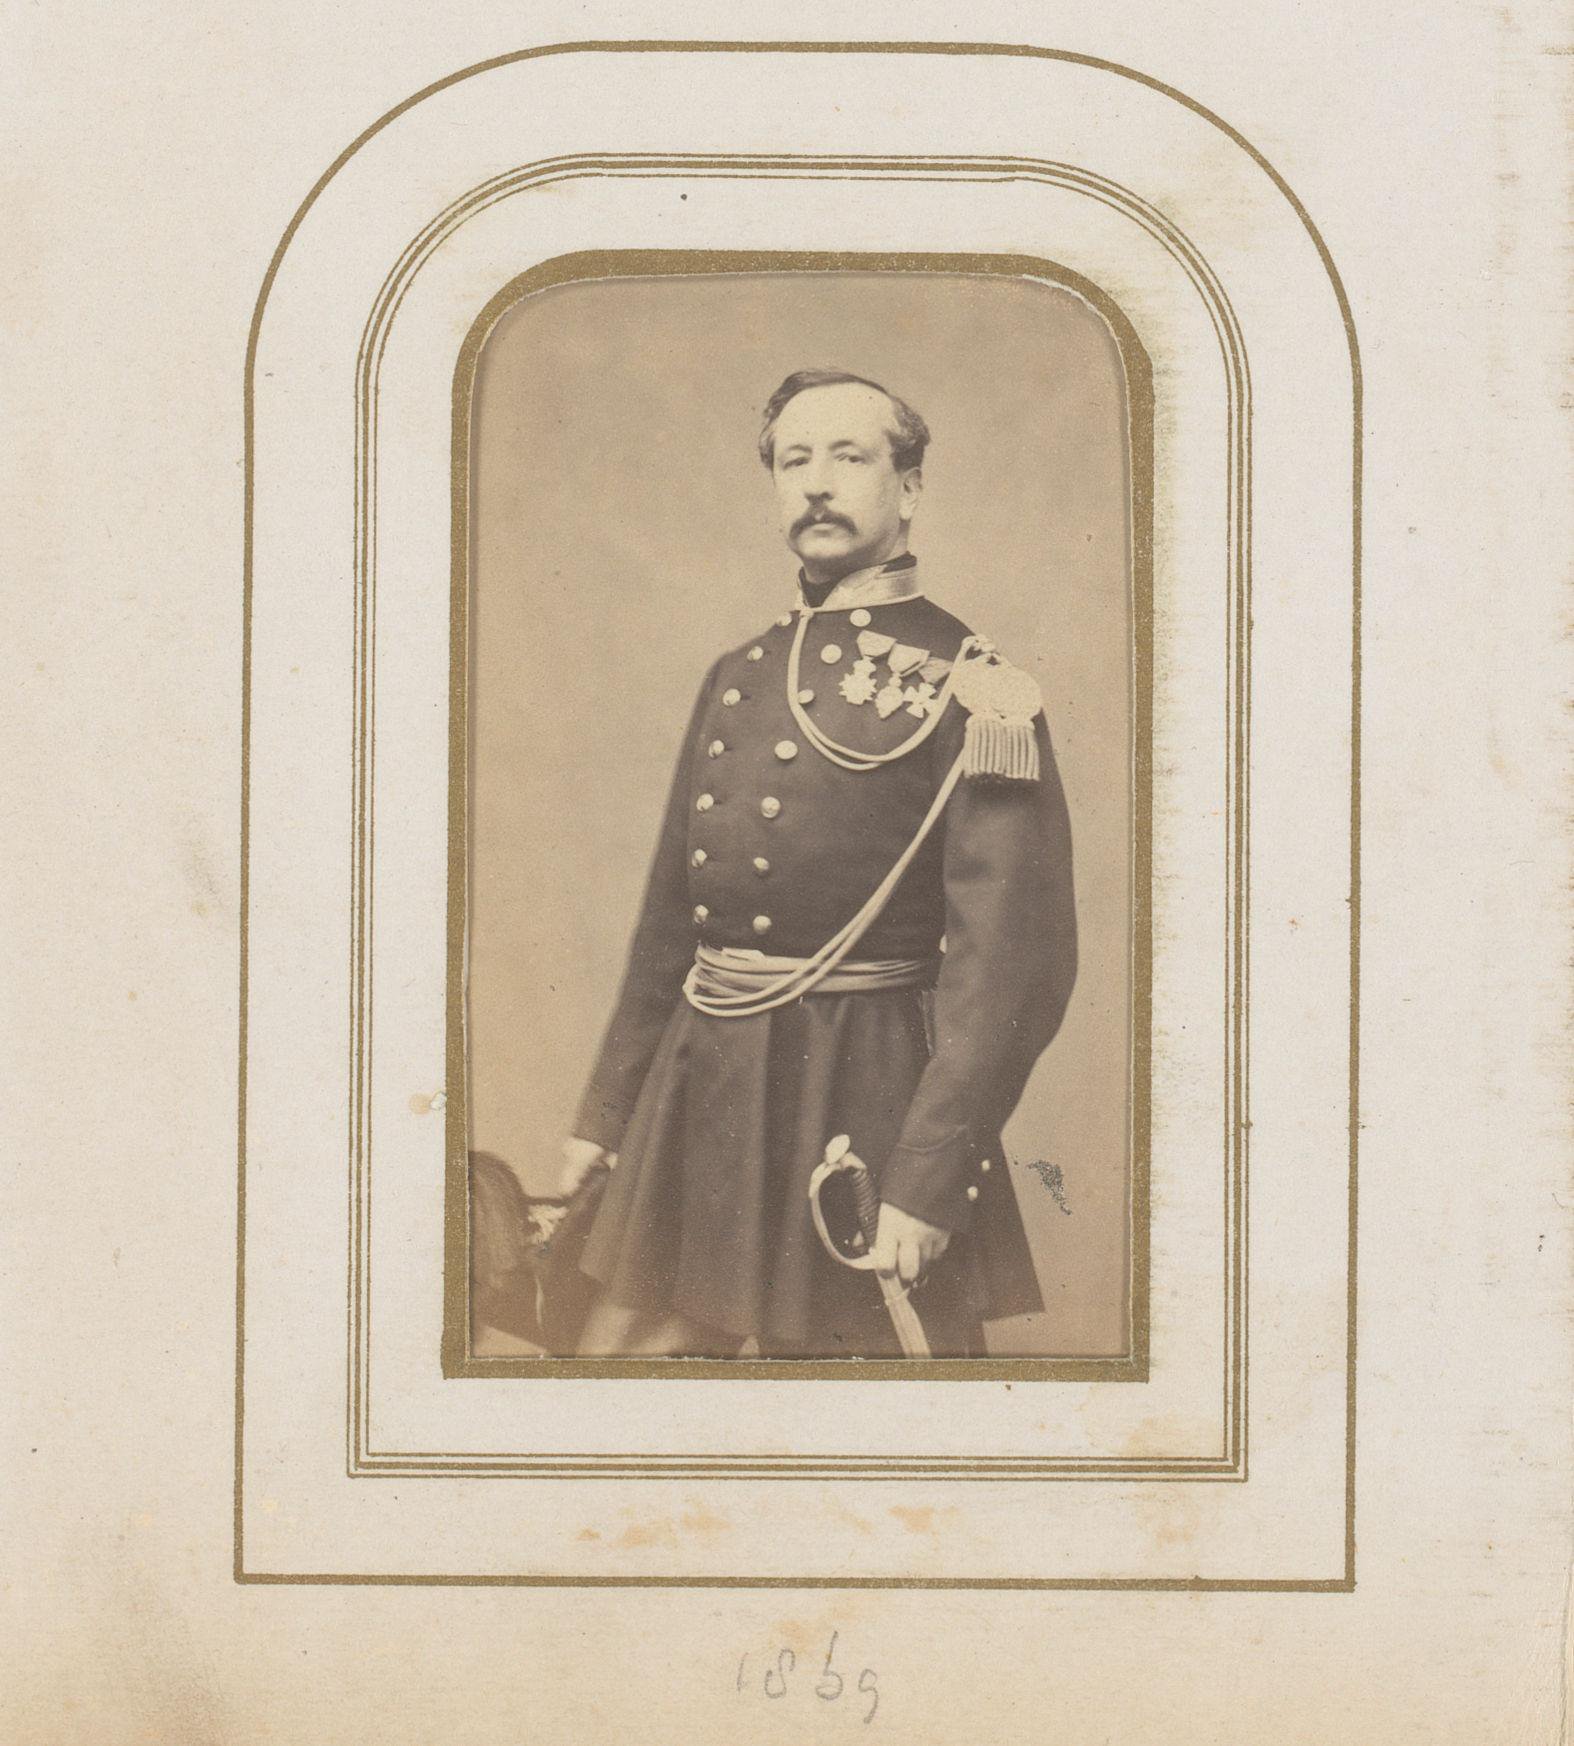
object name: photograph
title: Portret van een man met zwaard in uniform met medailles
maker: edouard thomassin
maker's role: publisher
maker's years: 1818-1887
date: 1869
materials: cardboard, photographic support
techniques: albumen print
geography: paris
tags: historical persons, hacking and thrusting weapons: sword, medals and other marks of military honour, (military) uniforms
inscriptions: annotation: ‘à mon ami Lemoine/ [...] amitié/ [...]/ Ch. d. Savoye/ mars 1869’, inscription: ‘Thomassin/ Photographe/ 39, Boulevard des Capucines, 39/ Paris’